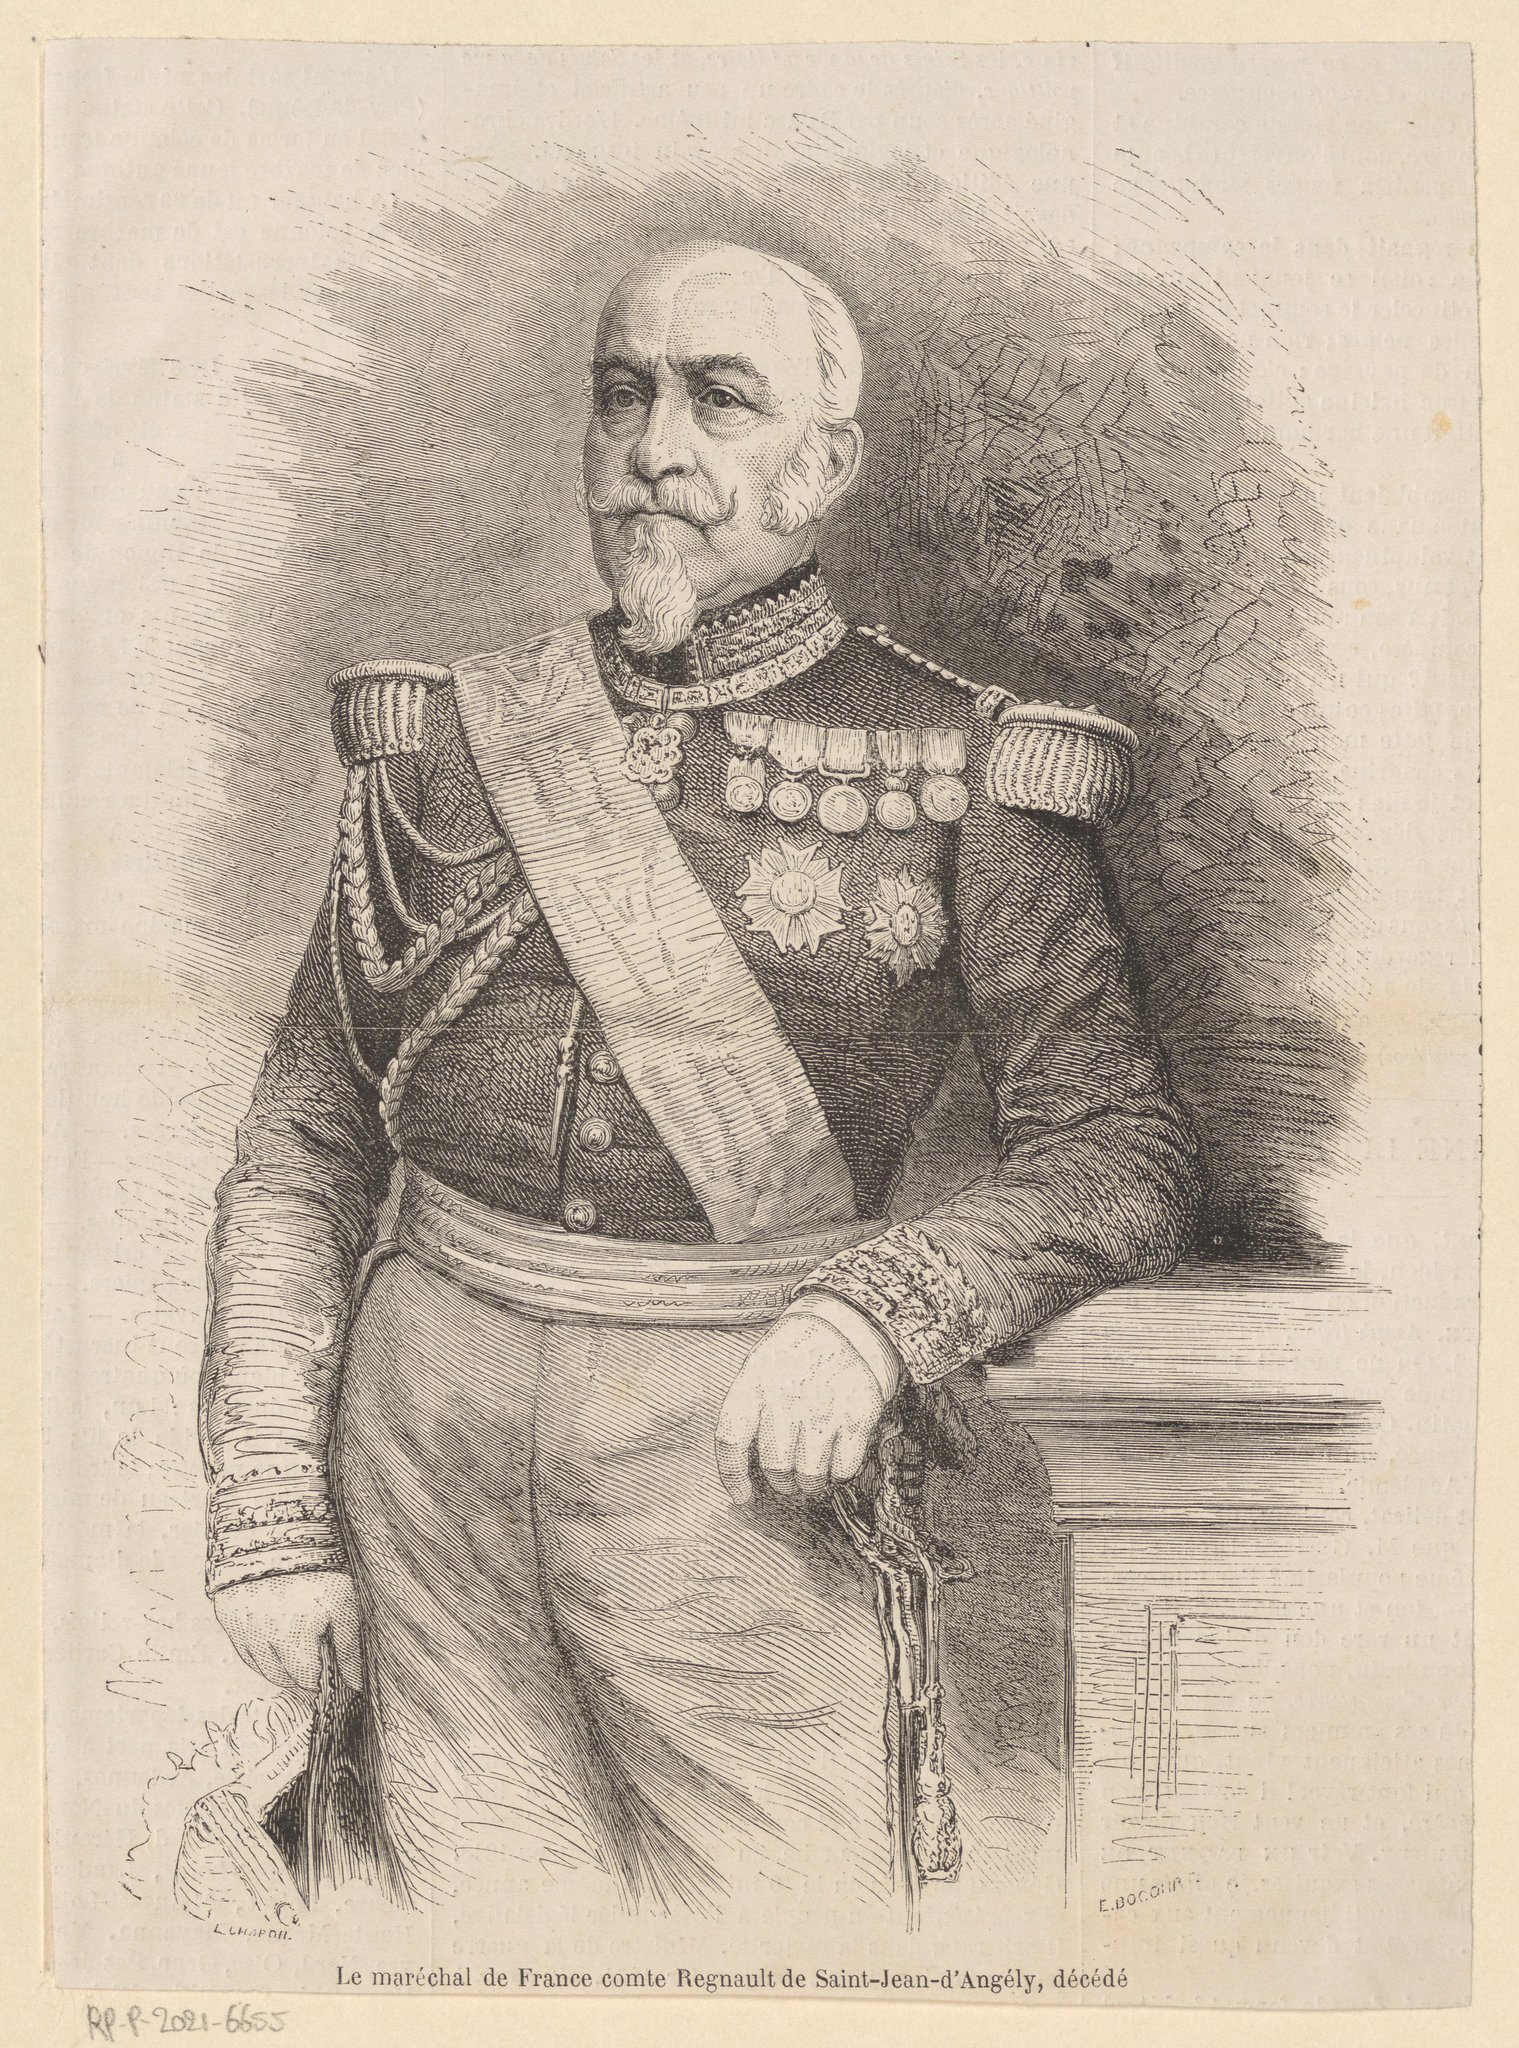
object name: print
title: Portret van een onbekende man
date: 1870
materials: paper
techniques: letterpress printing, engraving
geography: paris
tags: historical persons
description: Prent uit: Le monde illustré, nr. 670, 12 februari 1870.